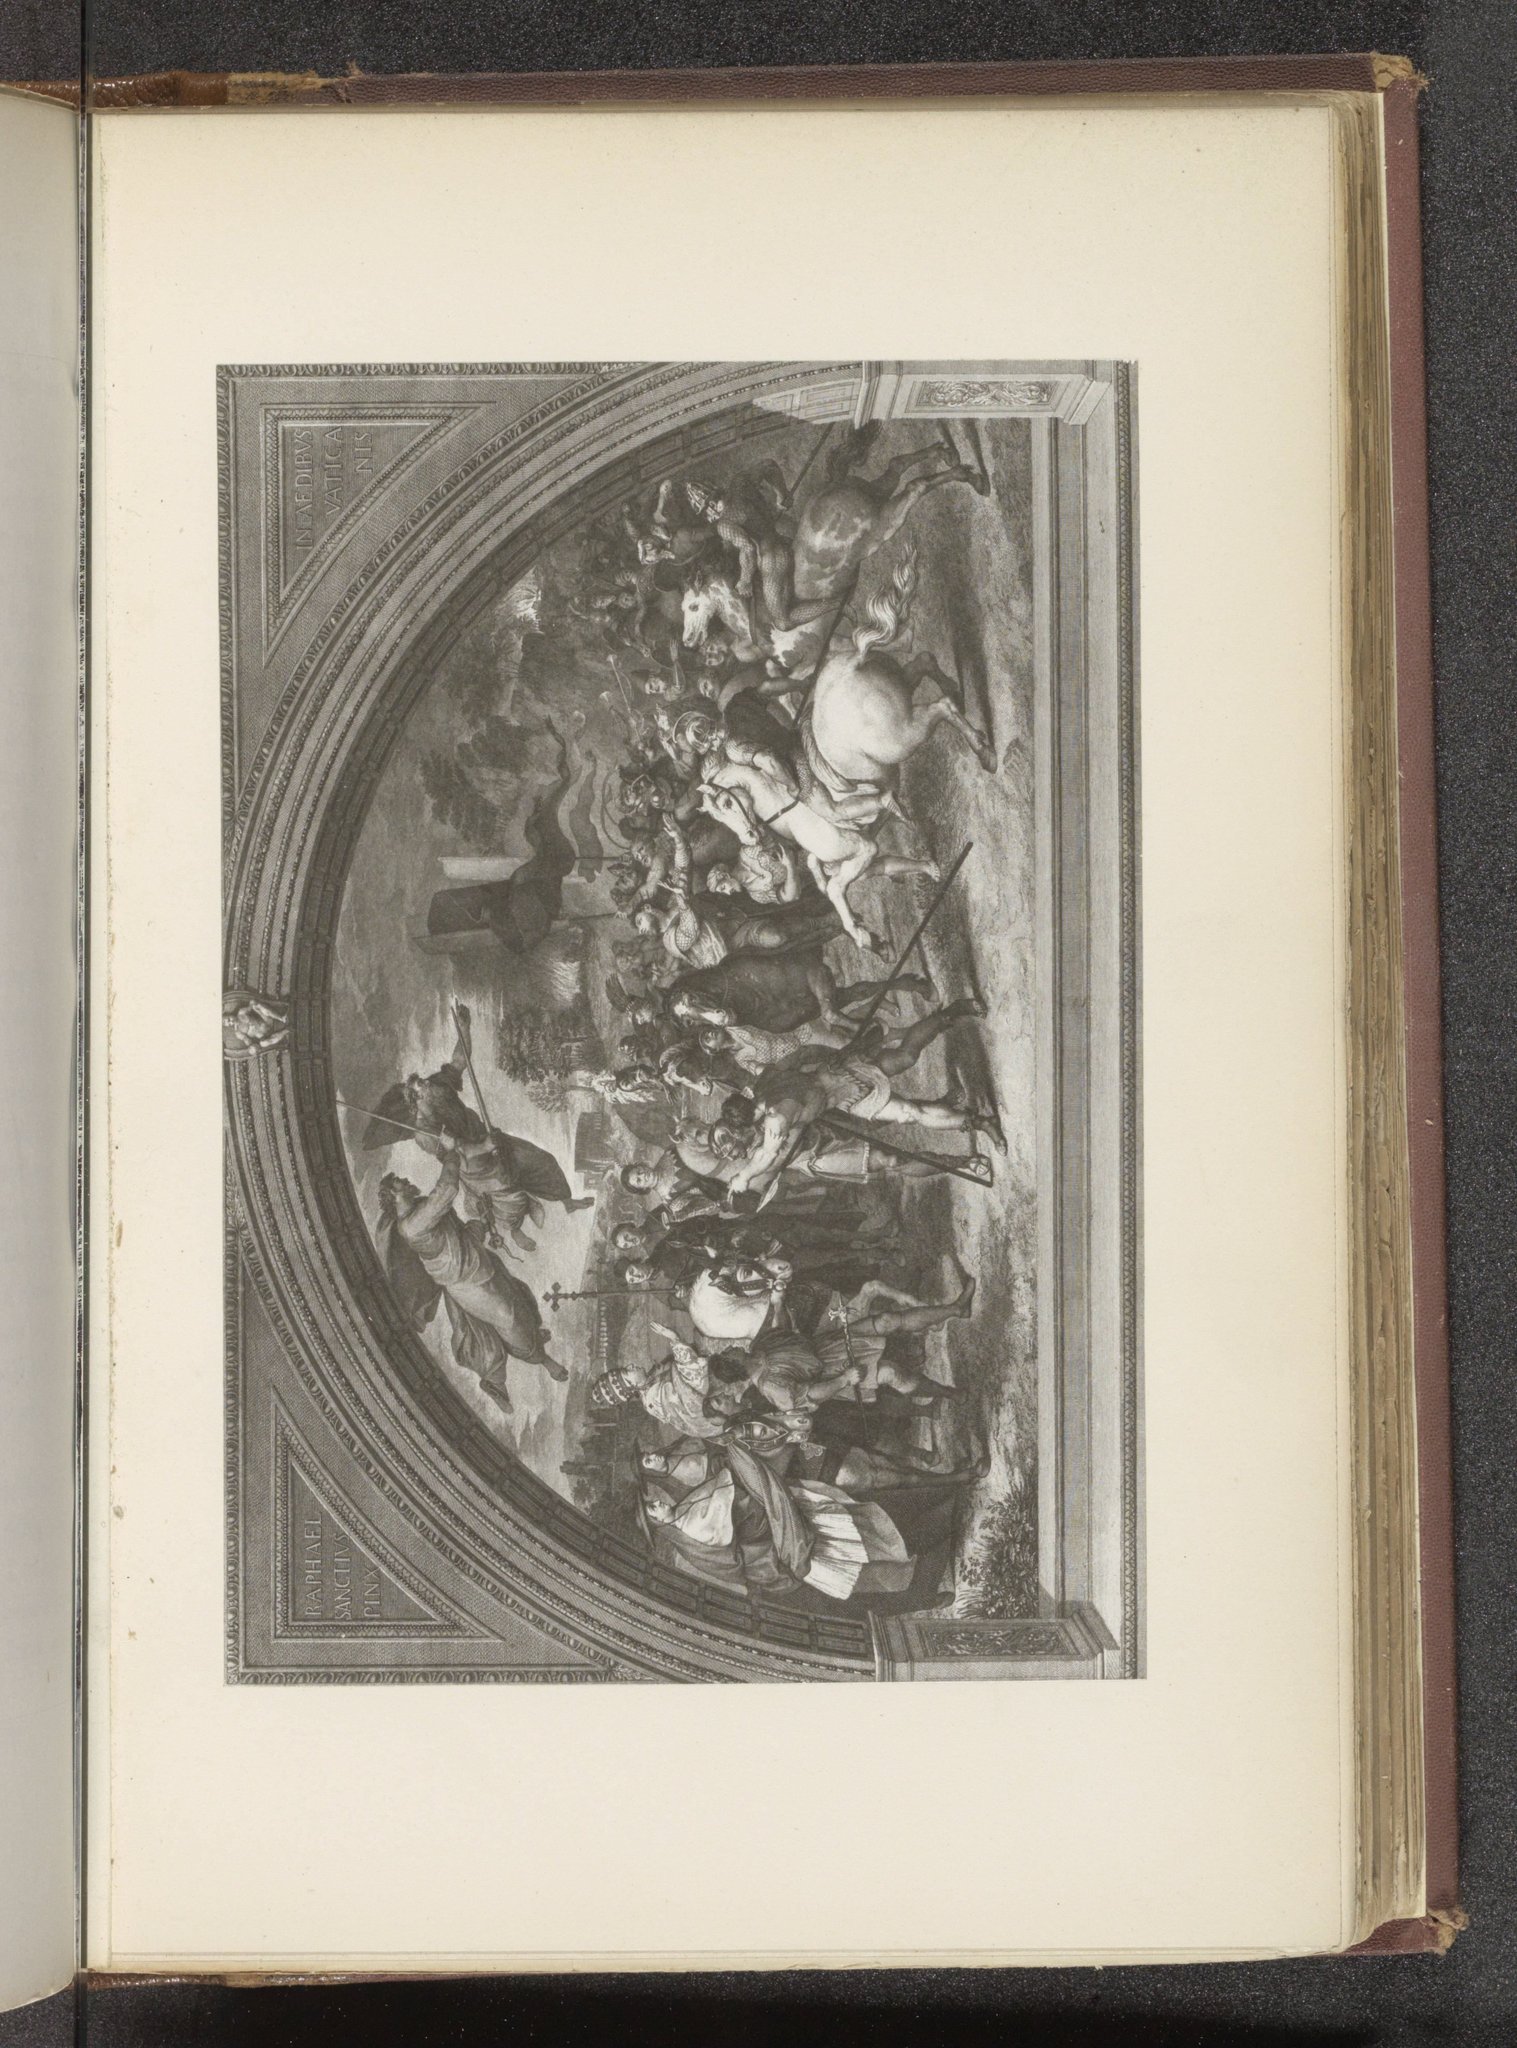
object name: reproduction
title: Fotoreproductie van het fresco De ontmoeting tussen Leo de Grote en Attila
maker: Anonymous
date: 1872-1882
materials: paper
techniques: woodburytype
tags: rome, peace negotiations